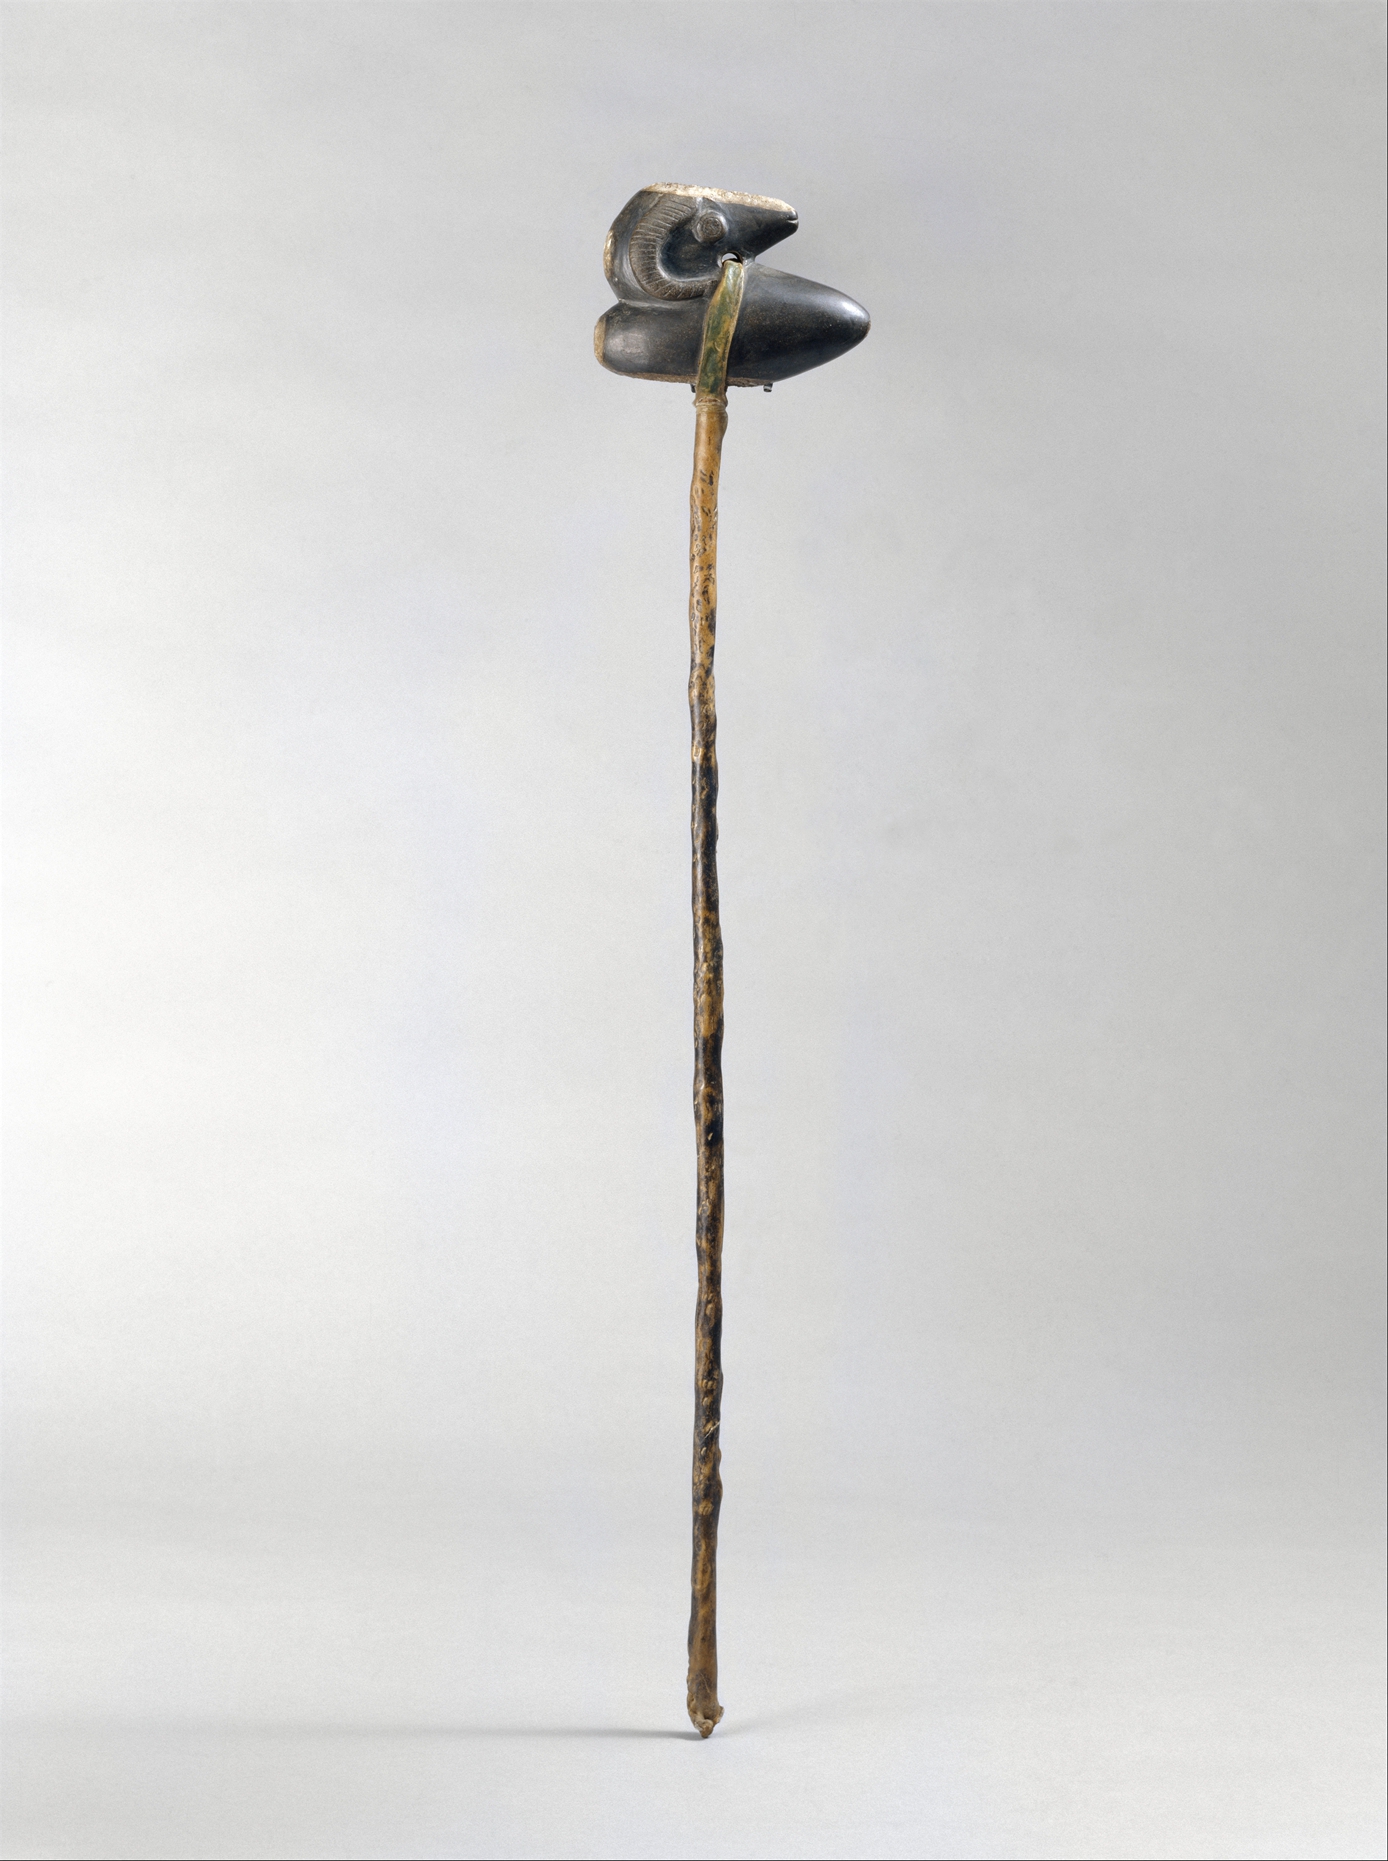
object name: club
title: Club (skullcracker)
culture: central plains sioux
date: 1870-1875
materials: stone, wood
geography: united states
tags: weapons